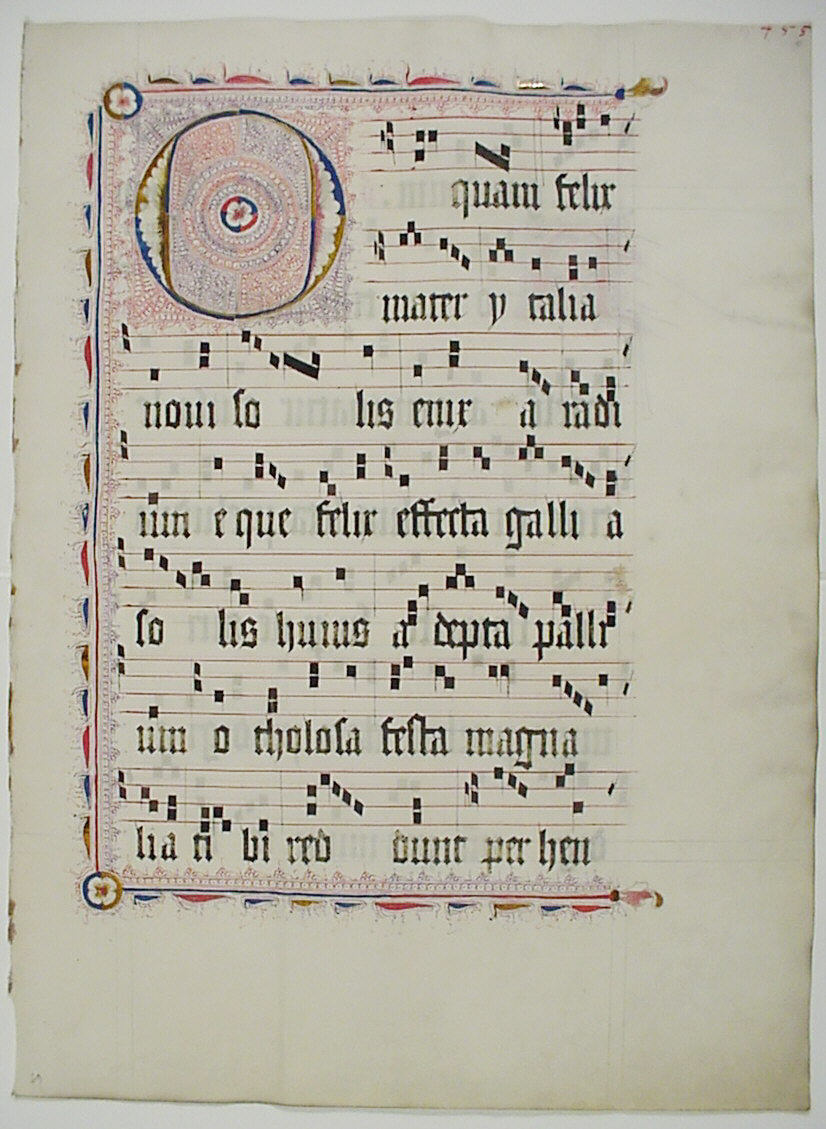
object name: antiphonary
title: Manuscript Leaf with Initial O, from an Antiphonary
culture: german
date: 1426-1450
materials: ink, metal leaf, parchment, paint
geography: germany